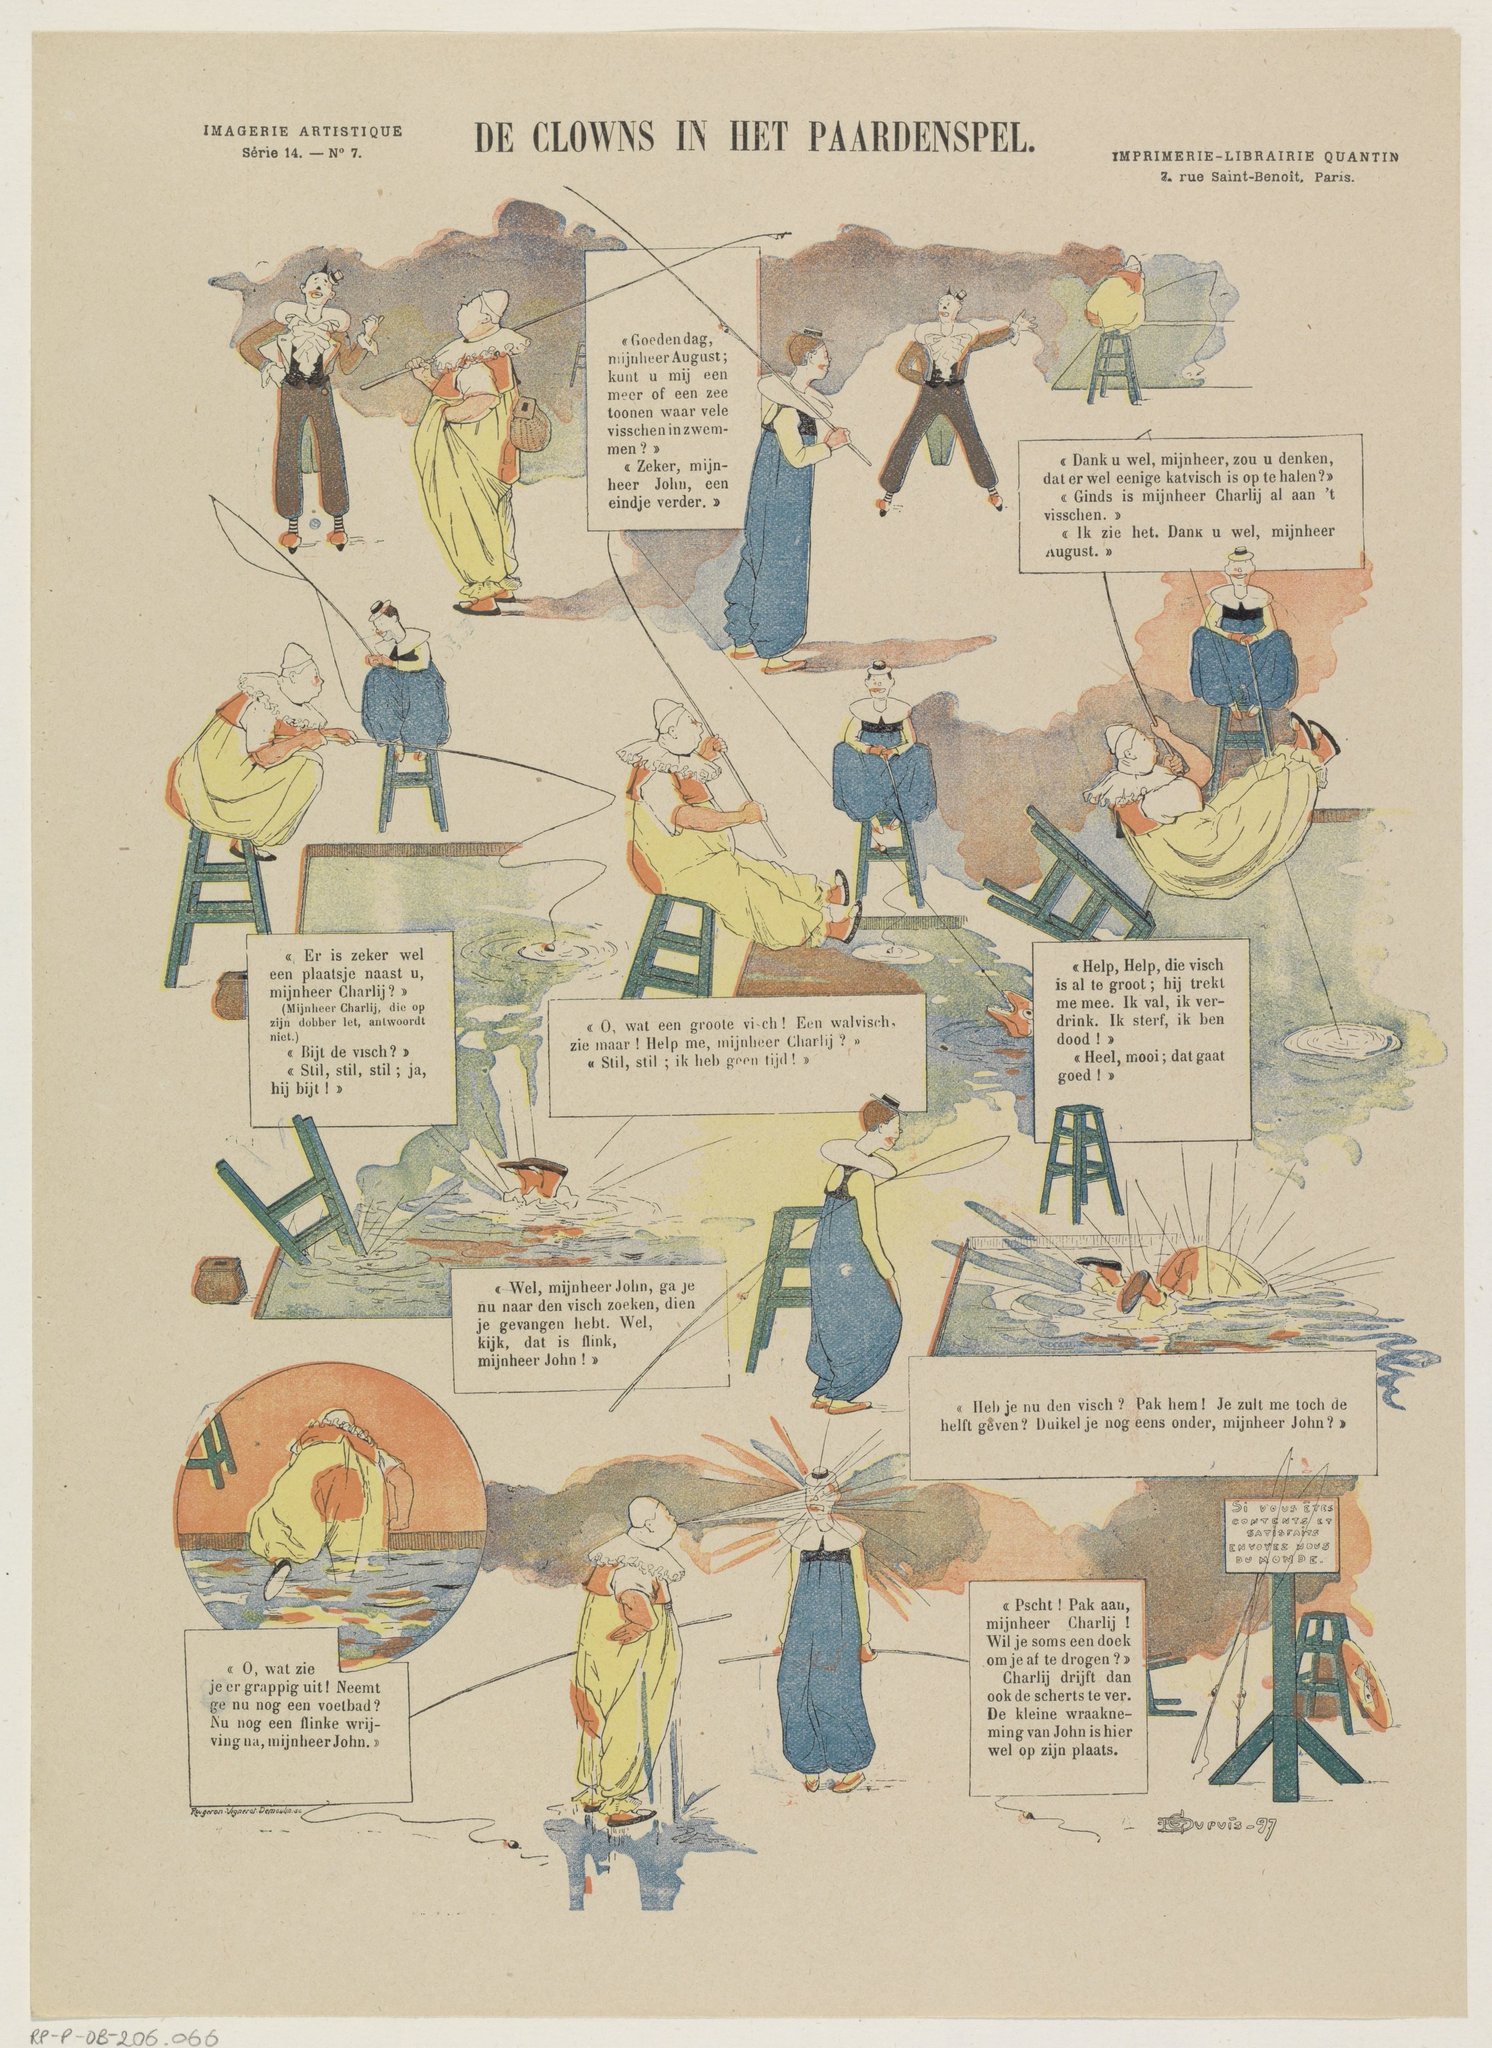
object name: print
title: Imagerie Artistique / Série 14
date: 1876-1890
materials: paper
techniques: lithograph, letterpress printing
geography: paris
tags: fishing (sports), tales and fairy tales, clown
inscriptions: collector's mark: Lugt 2760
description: Blad met voorstellingen van clowns die gaan vissen. Onder elke afbeelding een onderschrift. Genummerd linksboven: Série 14. - No. 7.